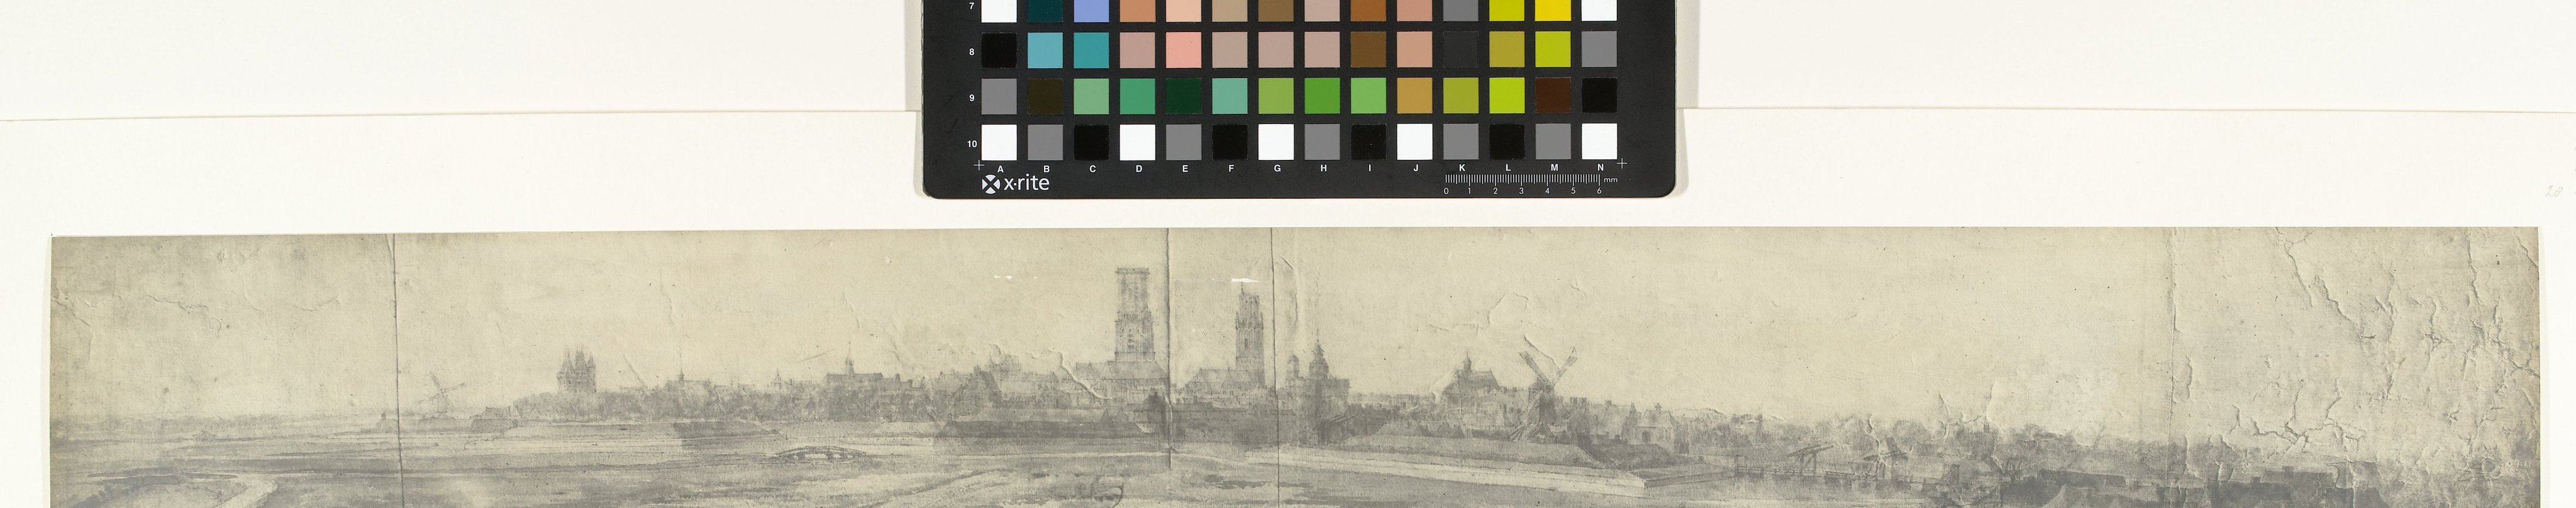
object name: photograph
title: Gezicht op Zwolle, 1672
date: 1900-1903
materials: paper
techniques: gelatin silver print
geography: france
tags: lodewijk xiv (koning van frankrijk), city-view, and landscape with man-made constructions, rampjaar (disaster year)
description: Niet in Frederik Muller; door het RPK toegevoegd nummer. Onderdeel van een groep van ca. 50 foto's van tekeningen van de Franse inval in de Nederlanden in 1672 door Adam Frans van der Meulen, bewaard in de Manufacture Nationale des Gobelins te Parijs.